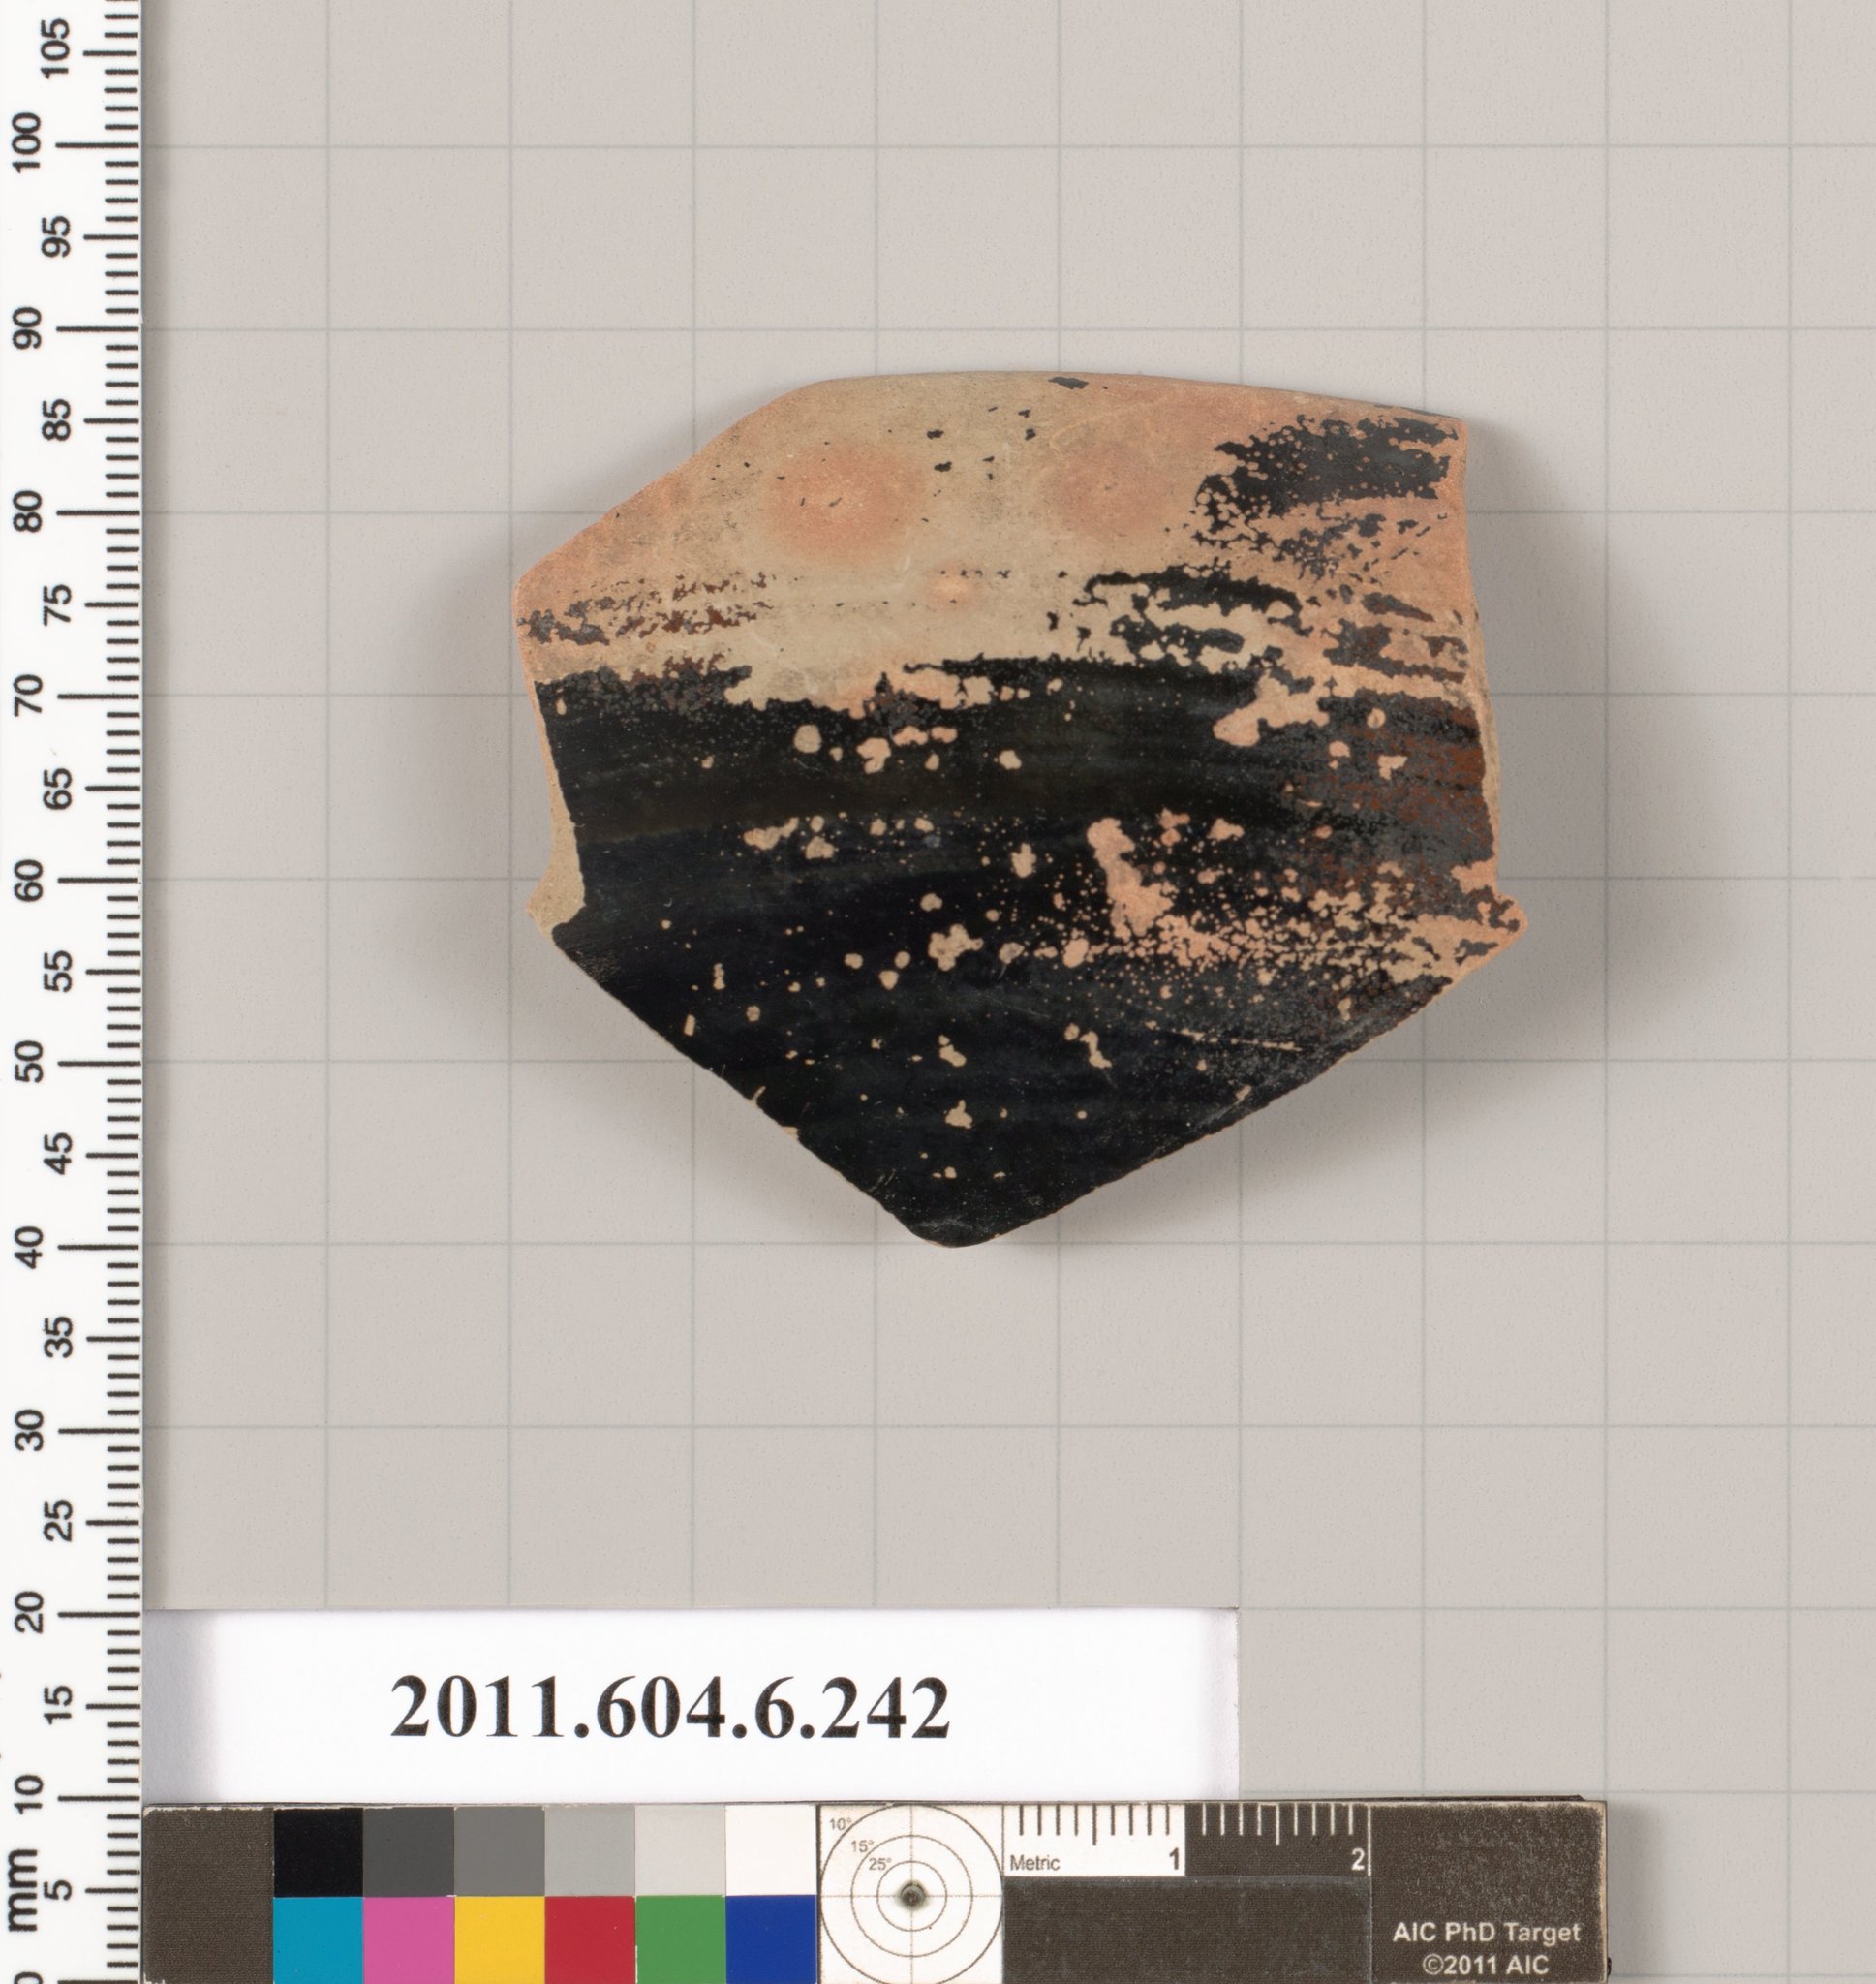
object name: fragment of a bowl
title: Terracotta rim fragment of a bowl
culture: greek, attic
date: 500-301 BCE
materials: terracotta